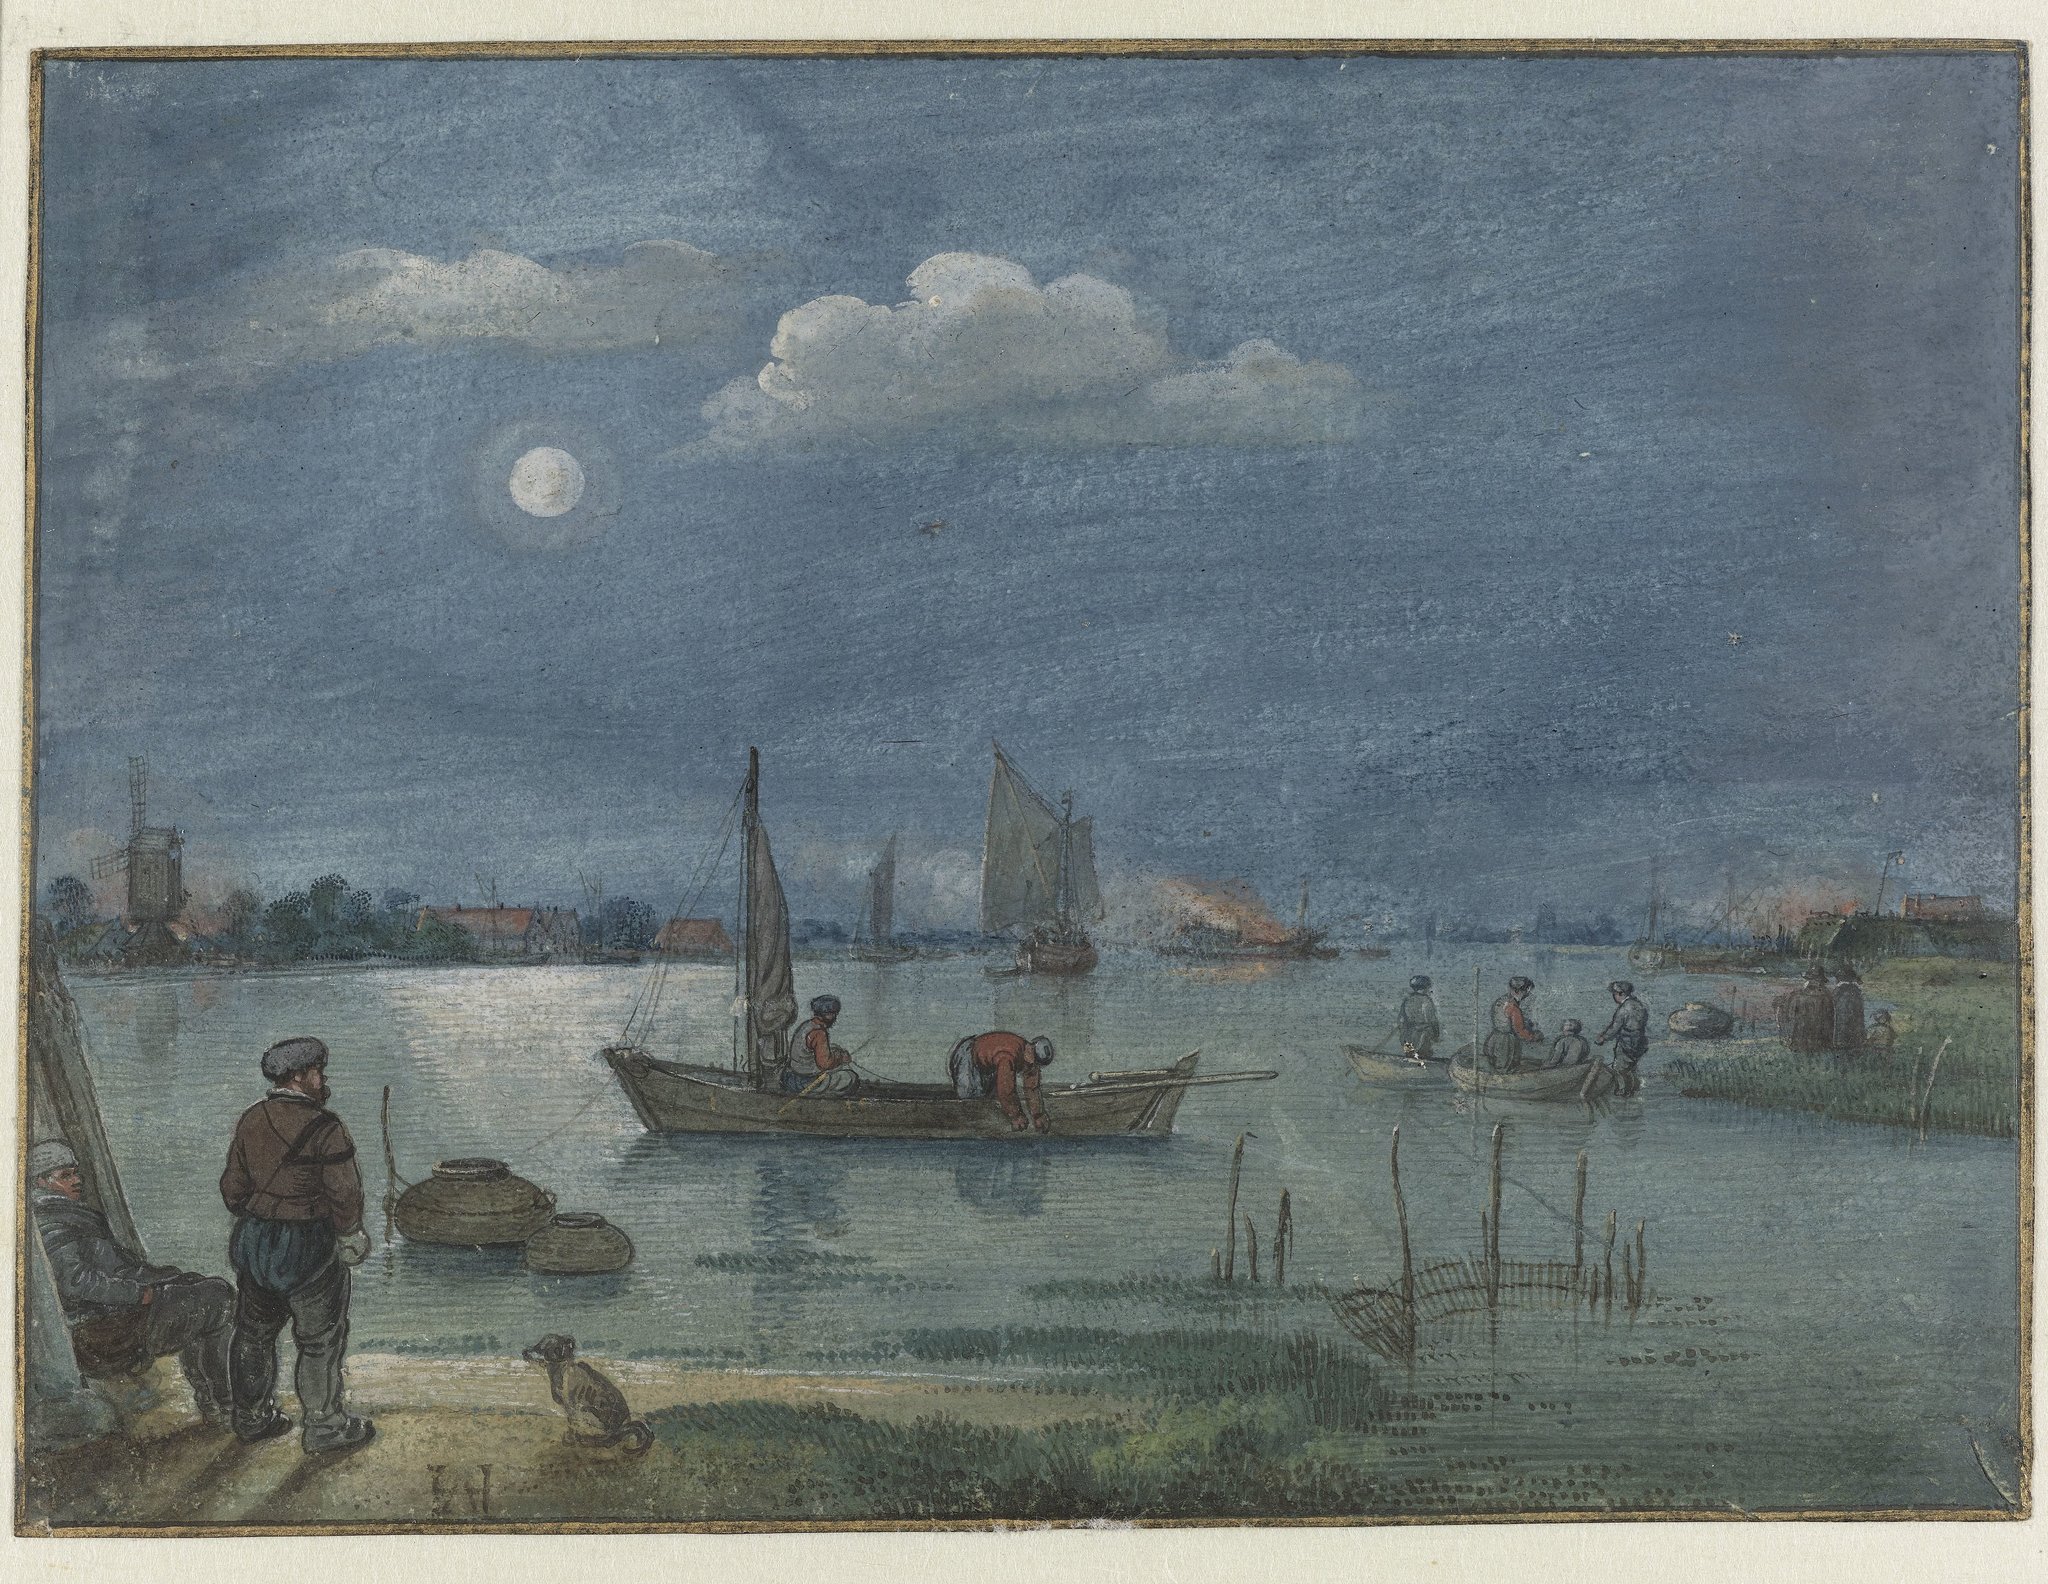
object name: drawing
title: Moonlit River Landscape with Fishermen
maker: hendrick avercamp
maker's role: draughtsman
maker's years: 1585-1634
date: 1625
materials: paint, ink, paper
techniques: brush, pen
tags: sailing-ship, sailing-boat, fresh-water fishery, moonlight